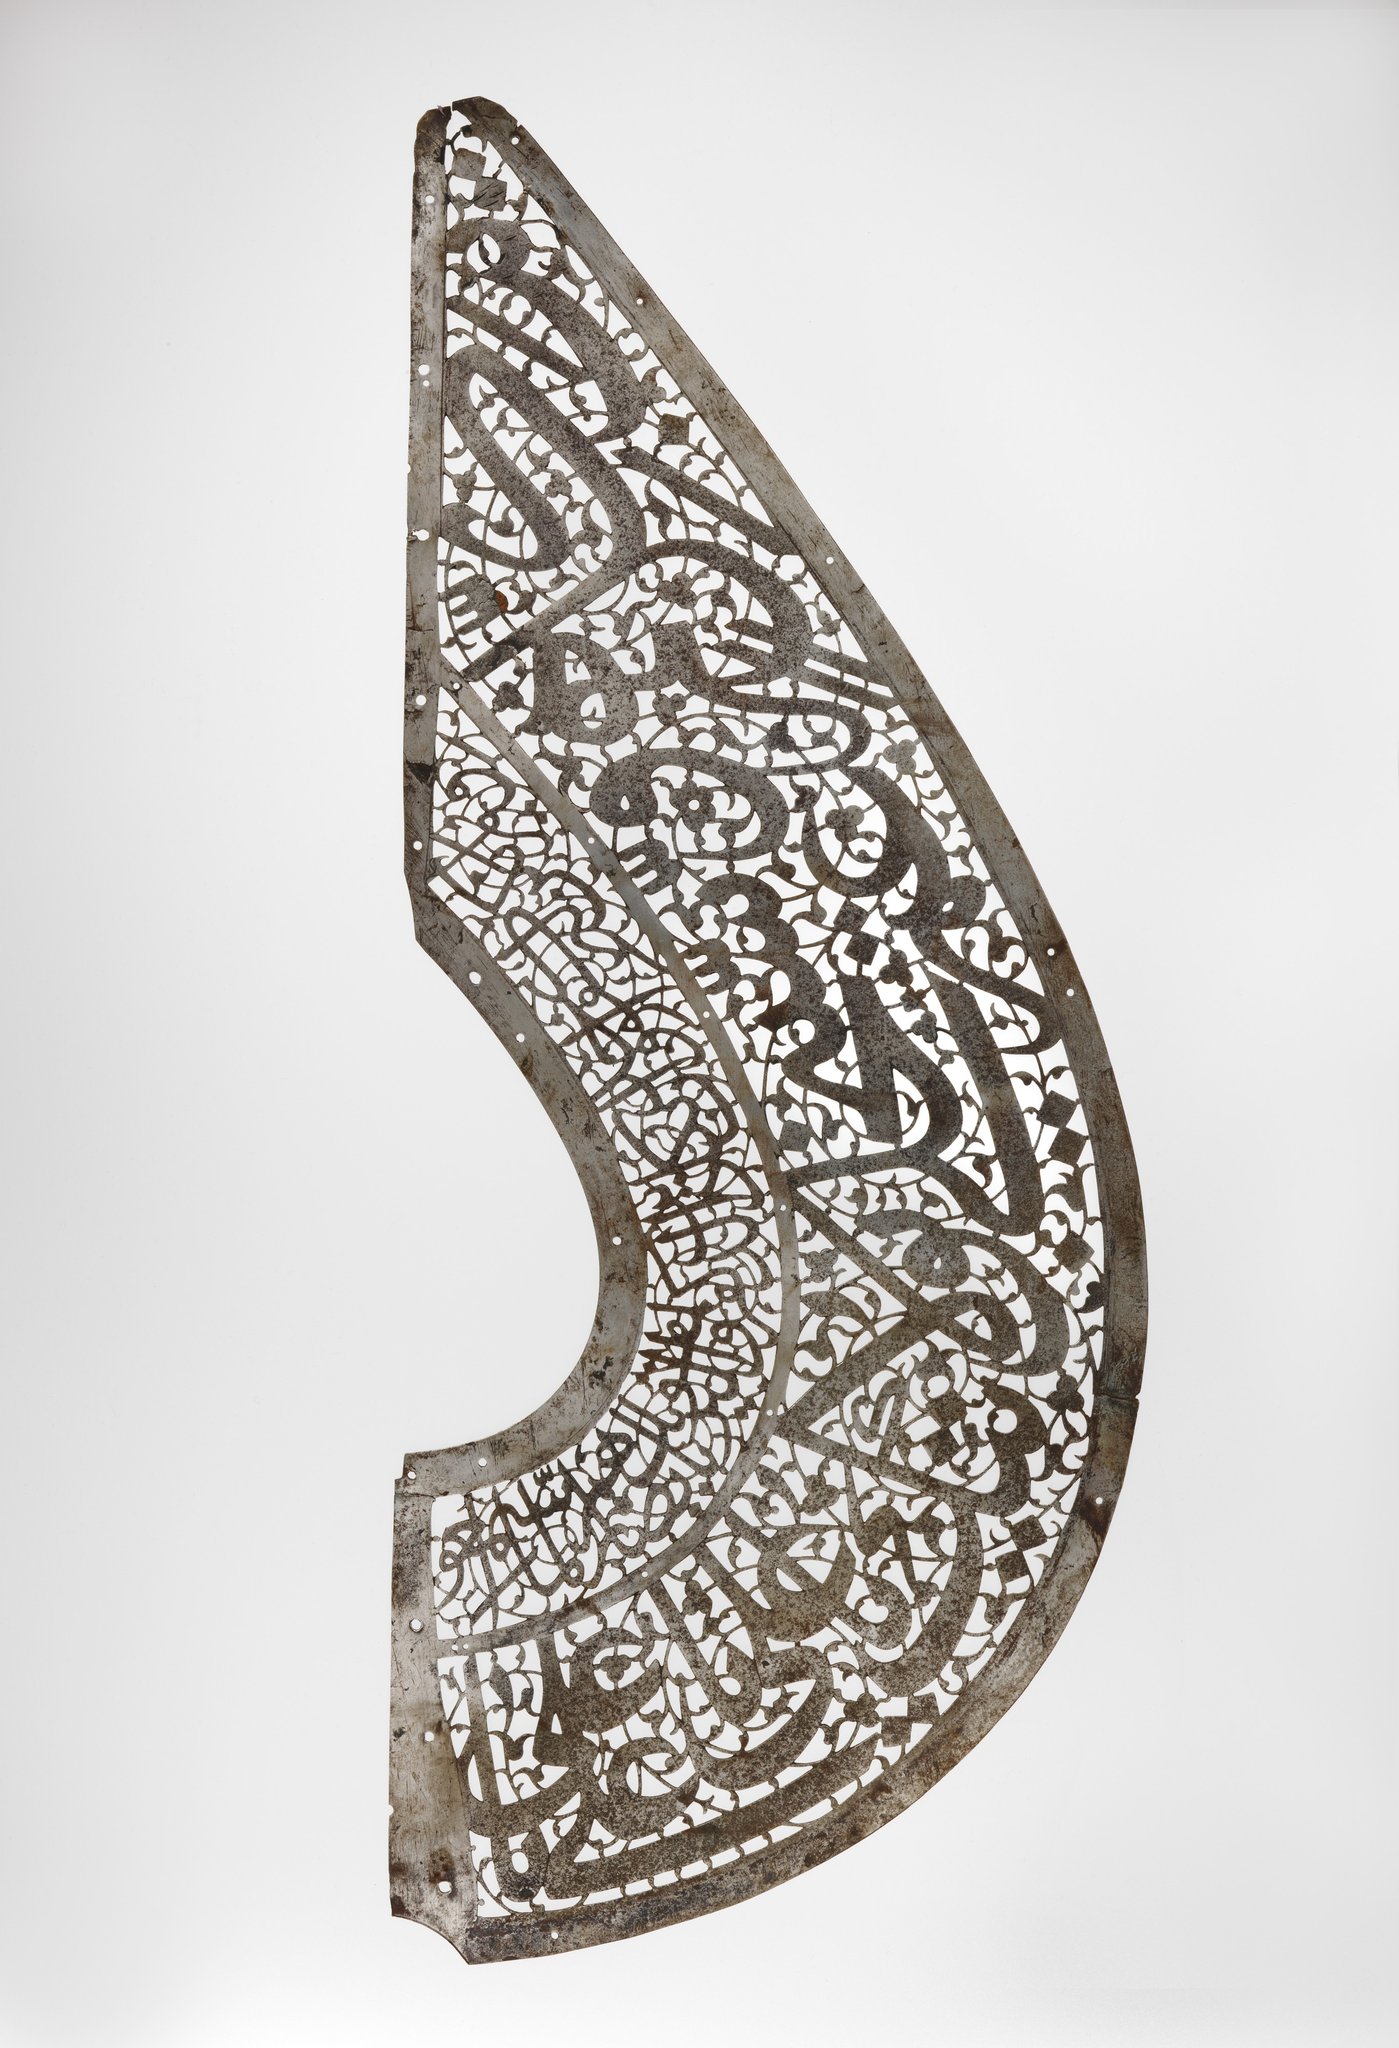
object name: standard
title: Fragment of a Standard ('Alam)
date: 1601-1700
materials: steel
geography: iran